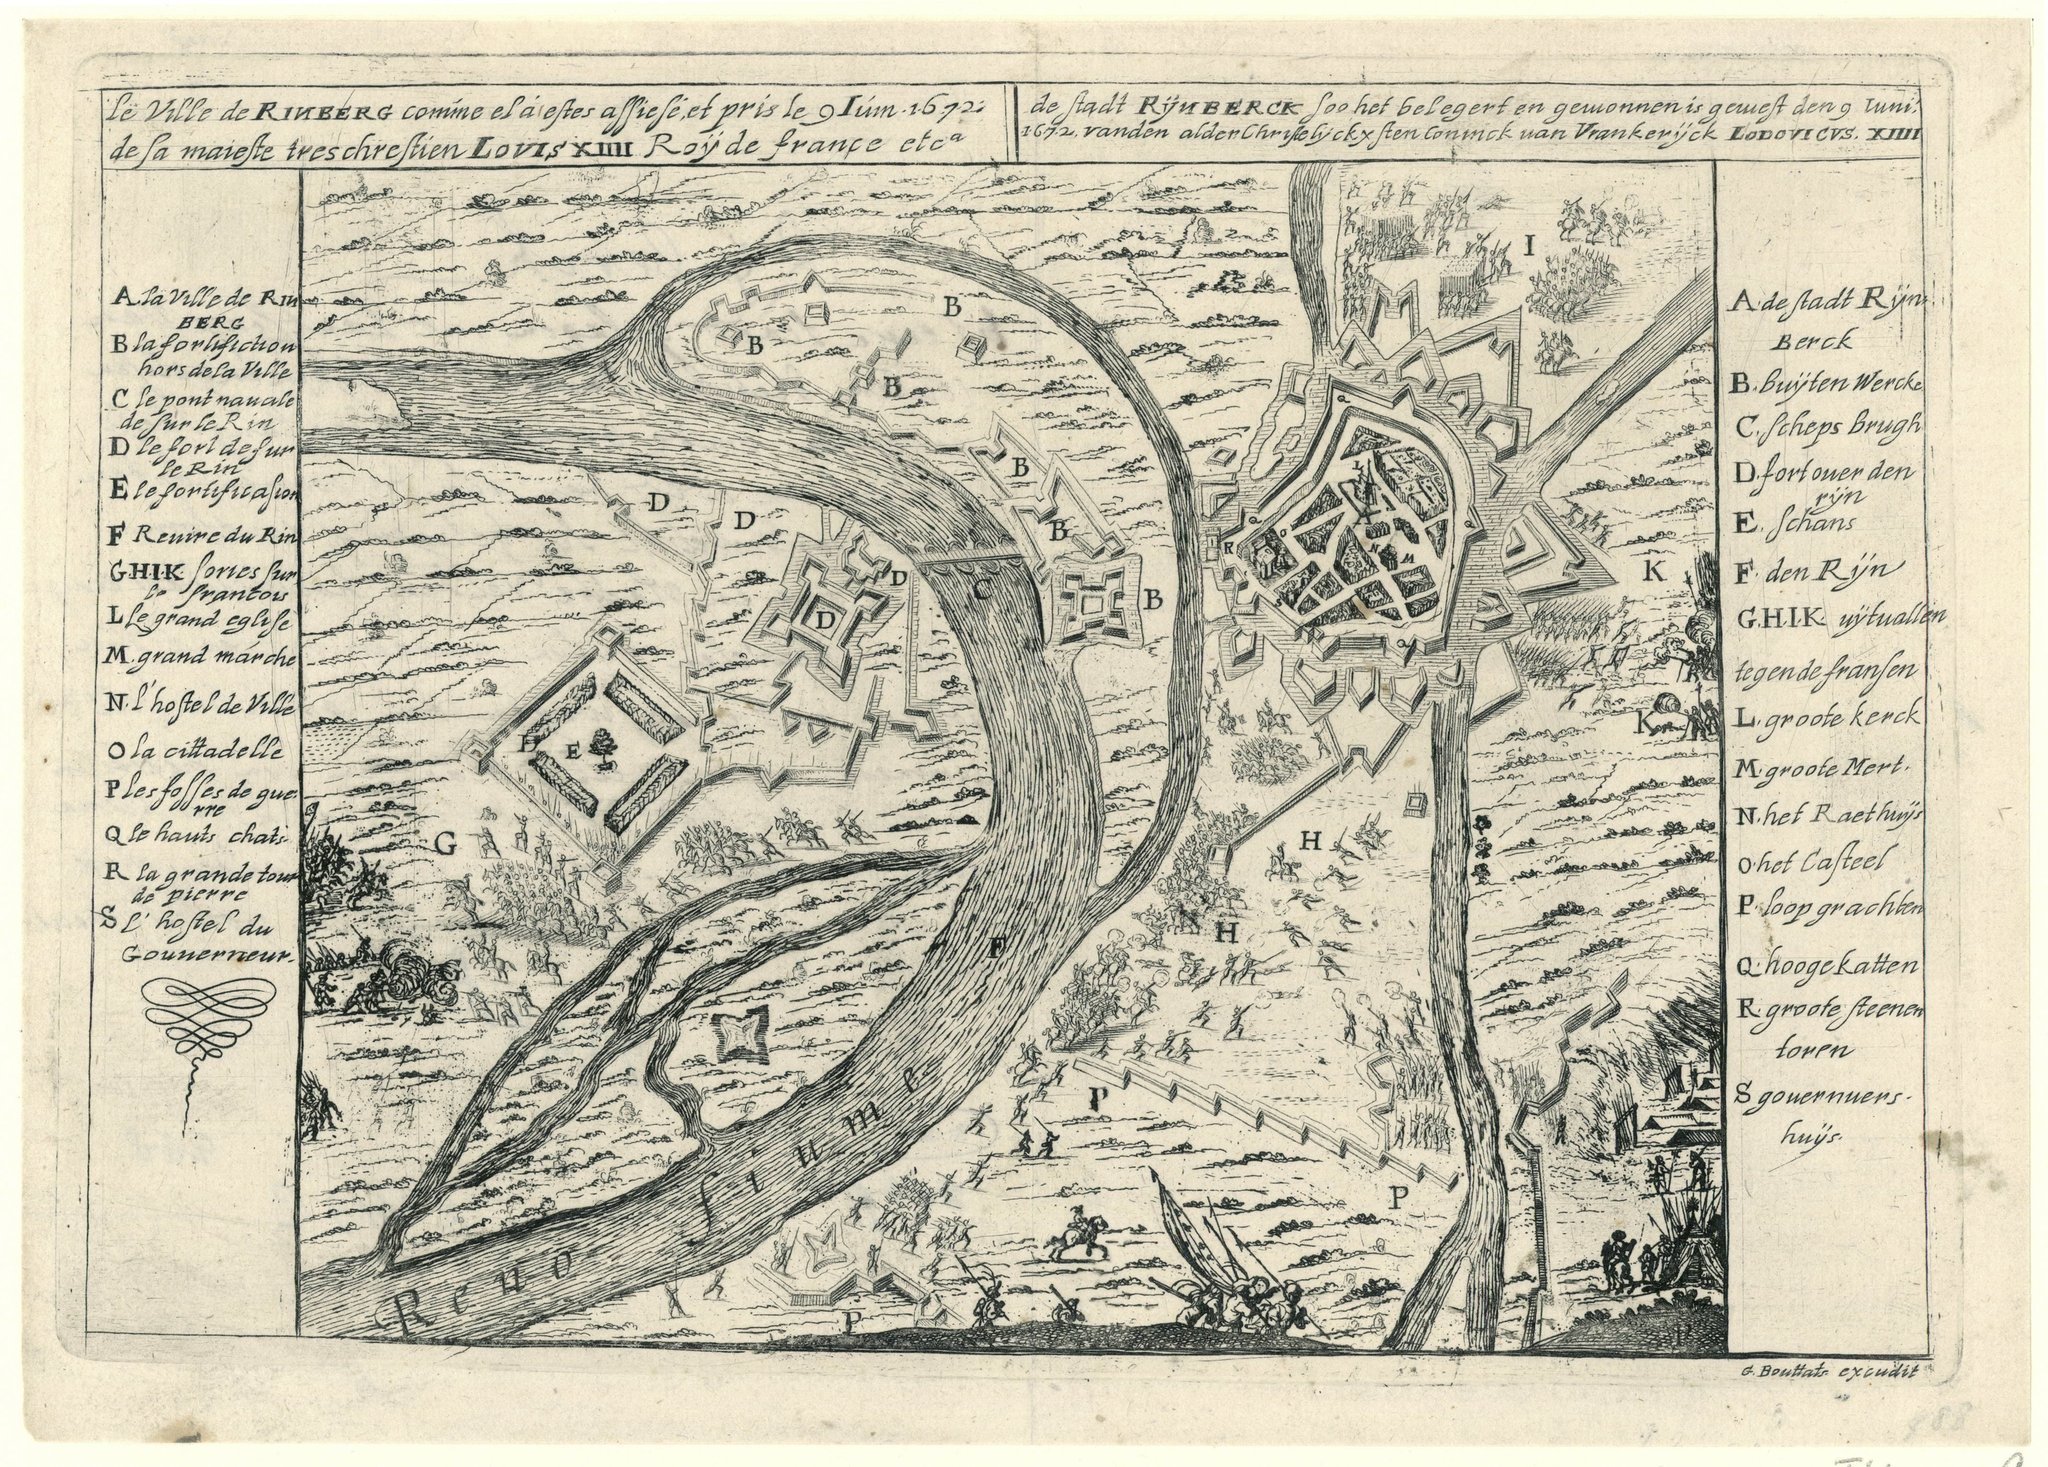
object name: print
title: Twaalf gezichten op vestingen en steden ingenomen door de Fransen en de bisschop van Munster in 1672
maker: gaspar bouttats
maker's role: print maker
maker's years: 1640-1695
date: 1672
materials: paper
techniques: etching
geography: antwerp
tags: maps of cities, rampjaar (disaster year)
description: Plattegrond met het beleg en inneming van Rheinberg door de Fransen op 9 juni 1672. Deze prent maakt deel uit van een groep van twaalf prenten, merendeels geëetst en uitgegeven door Gaspar Bouttats, met gezichten op vestingen en steden veroverd door de Fransen en Munstersen in 1672. Plattegronden met legenda's in Frans en Nederlands.